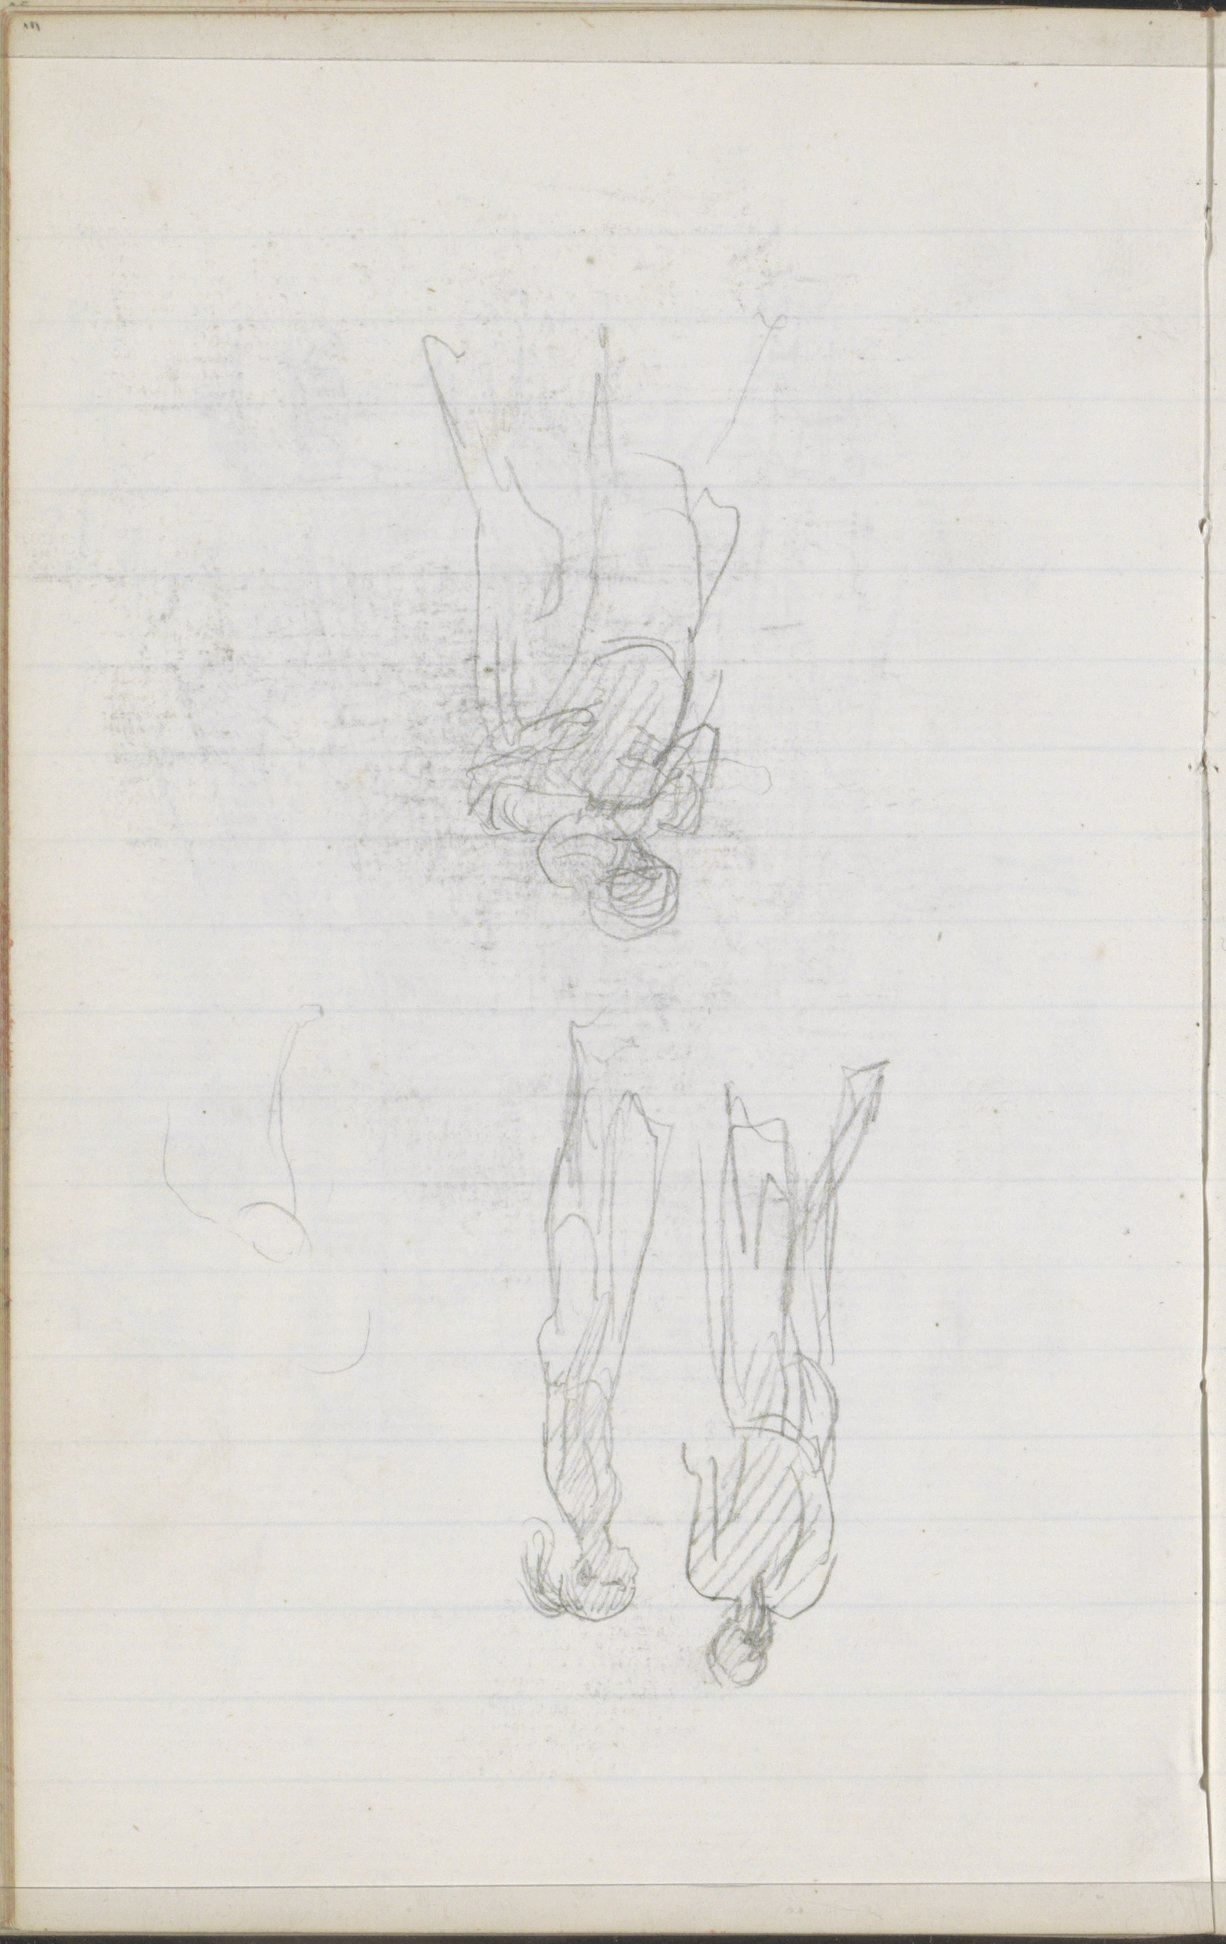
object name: sketchbook leaf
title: Figuurstudies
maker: marius bauer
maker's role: draughtsman, print maker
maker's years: 1867-1932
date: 1897-1898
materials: pencil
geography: india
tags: embracing each other, kissing, asiatic races and peoples: indians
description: Onder andere twee figuren die elkaar omhelzen. Pagina 111 uit een schetsboek met 62 bladen.